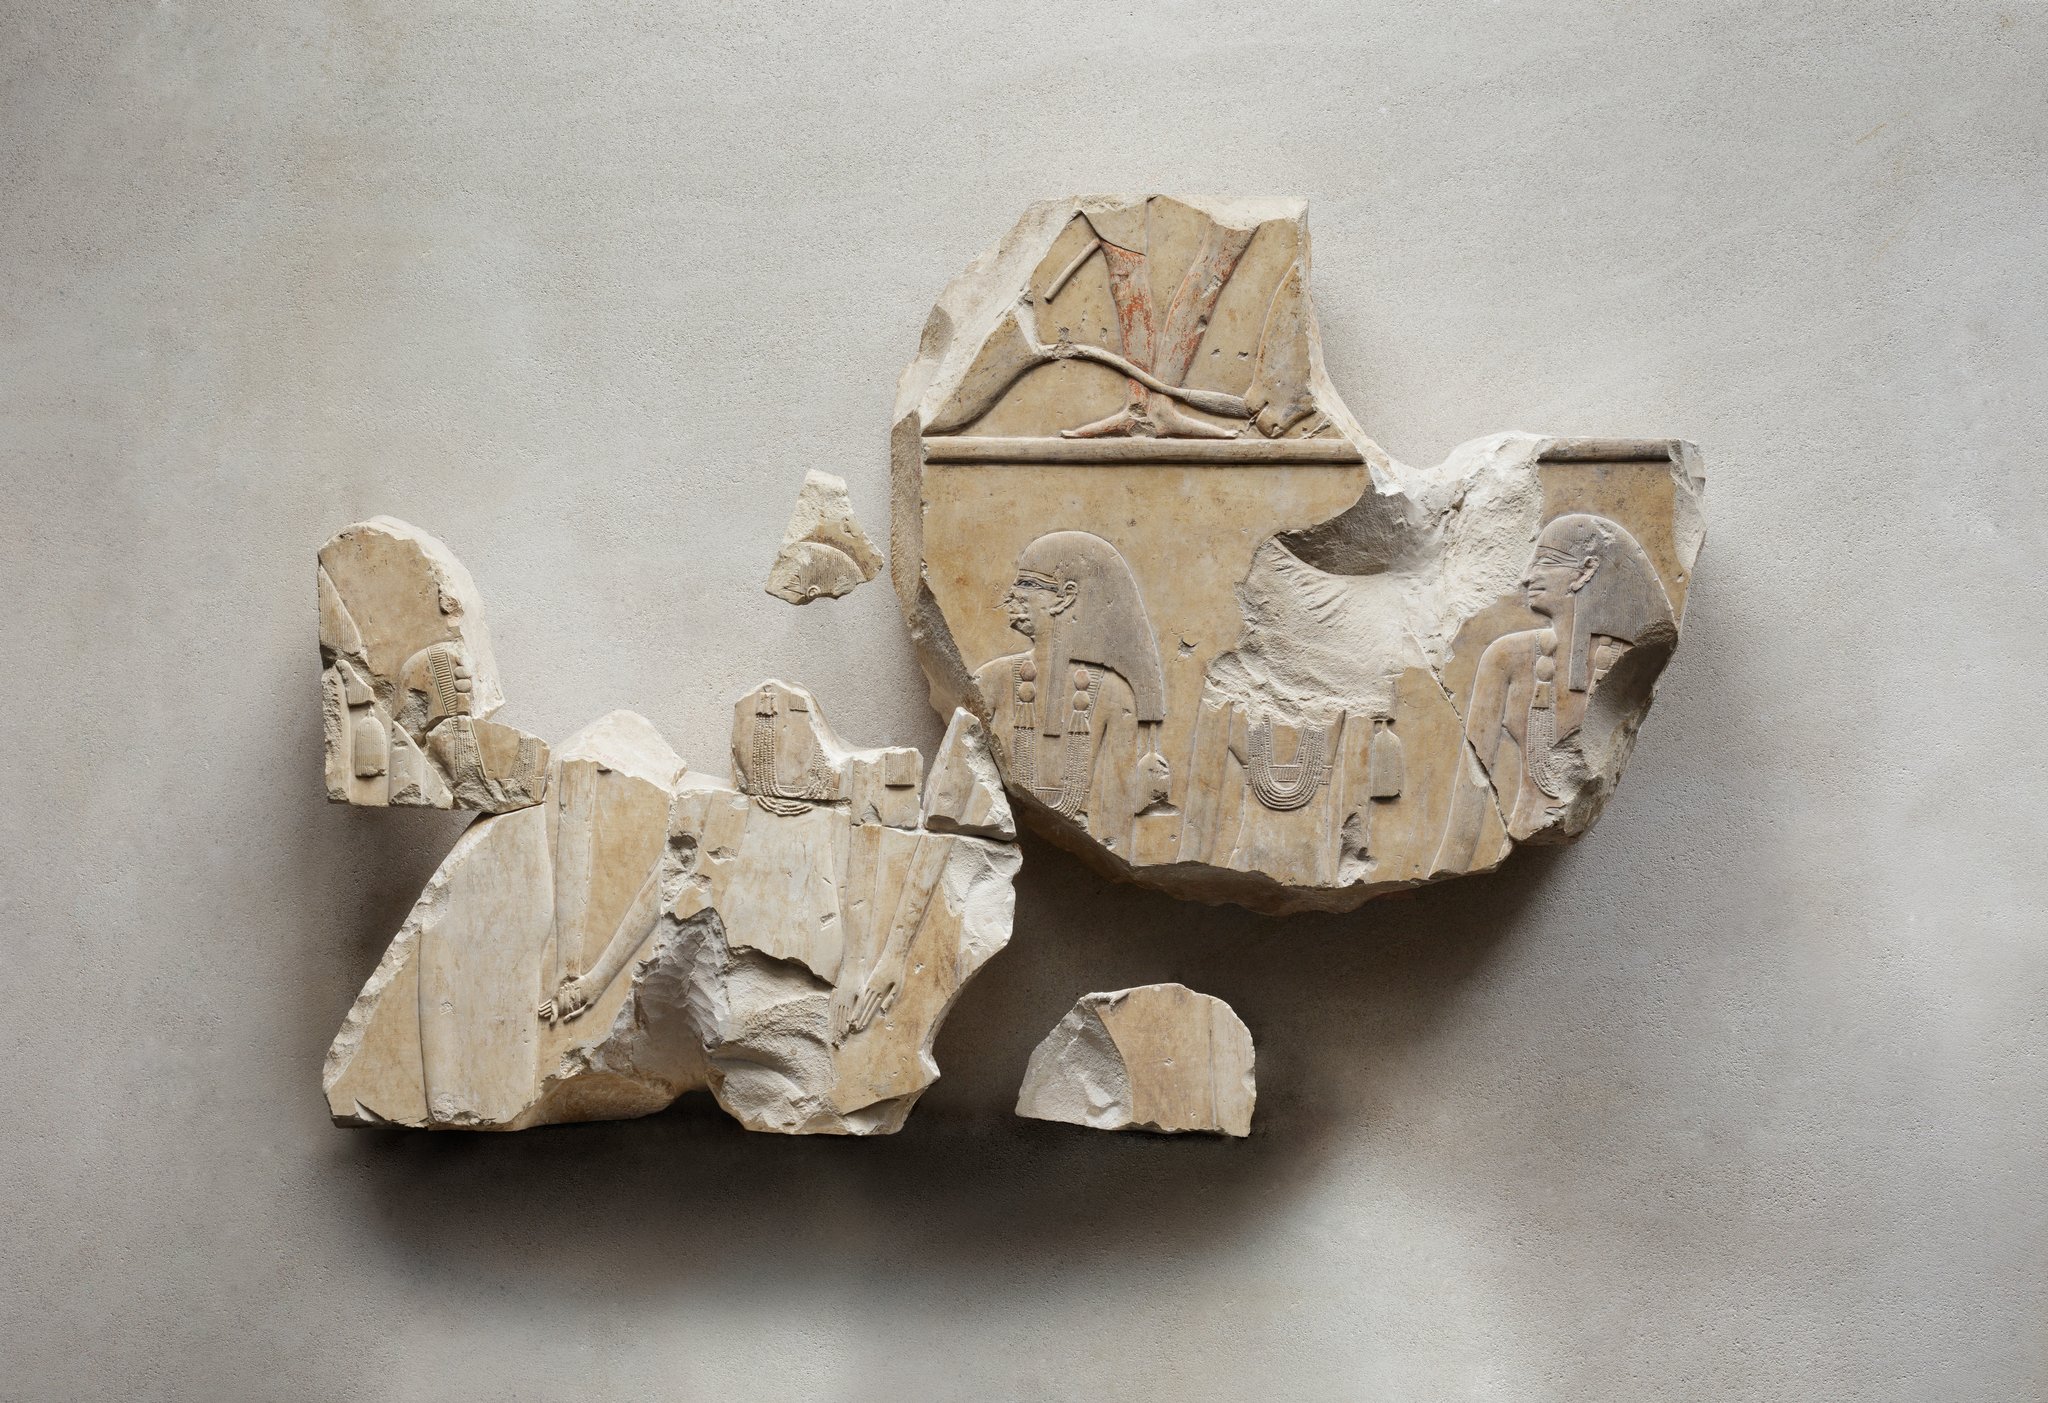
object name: relief, slaughtering and attendant moving left, neferu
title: Relief of slaughtering and attendants moving to the left - see 26.3.353-3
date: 2051-2030 BCE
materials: limestone, paint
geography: egypt